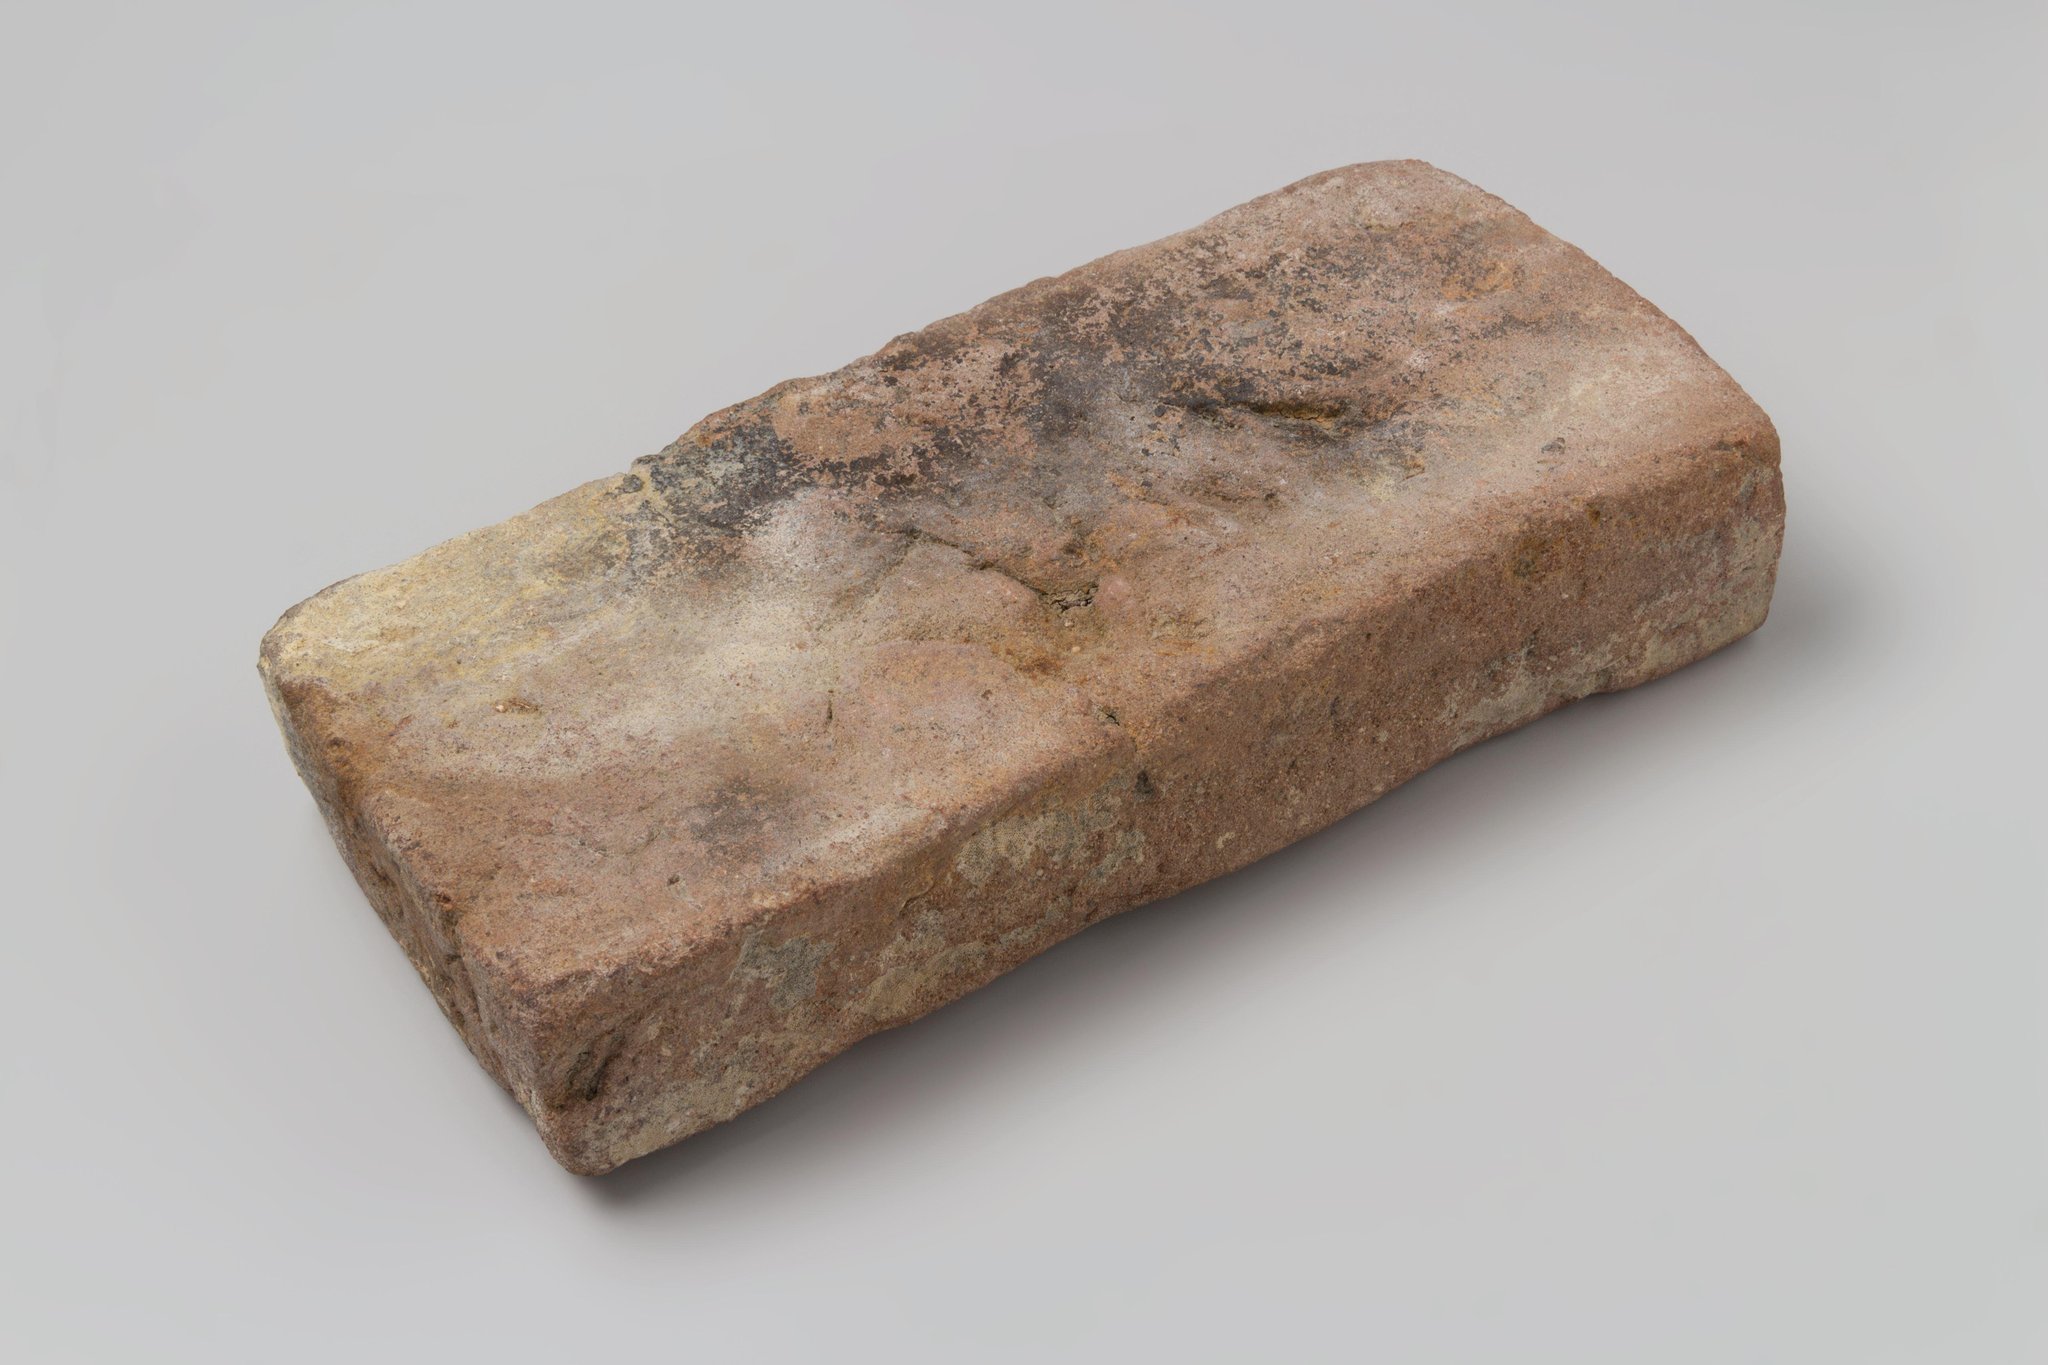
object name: brick clay product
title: Baksteen uit het wrak van de Oost-Indiëvaarder 't Vliegend Hart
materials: brick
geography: netherlands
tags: 't vliegend hart (schip), verenigde oostindische compagnie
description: Hele roodbruine baksteen, rechthoekig, oblong. Brick